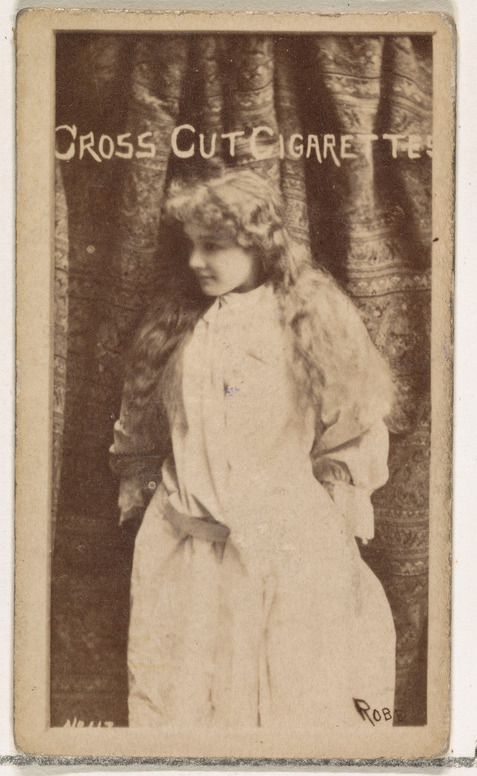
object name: print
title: Annie Robe, from the Actors and Actresses series (N145-1) issued by Duke Sons & Co. to promote Cross Cut Cigarettes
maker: w. duke, sons & co.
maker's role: publisher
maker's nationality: american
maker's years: 1870-1920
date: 1880-1889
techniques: albumen silver print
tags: portraits,women,actresses